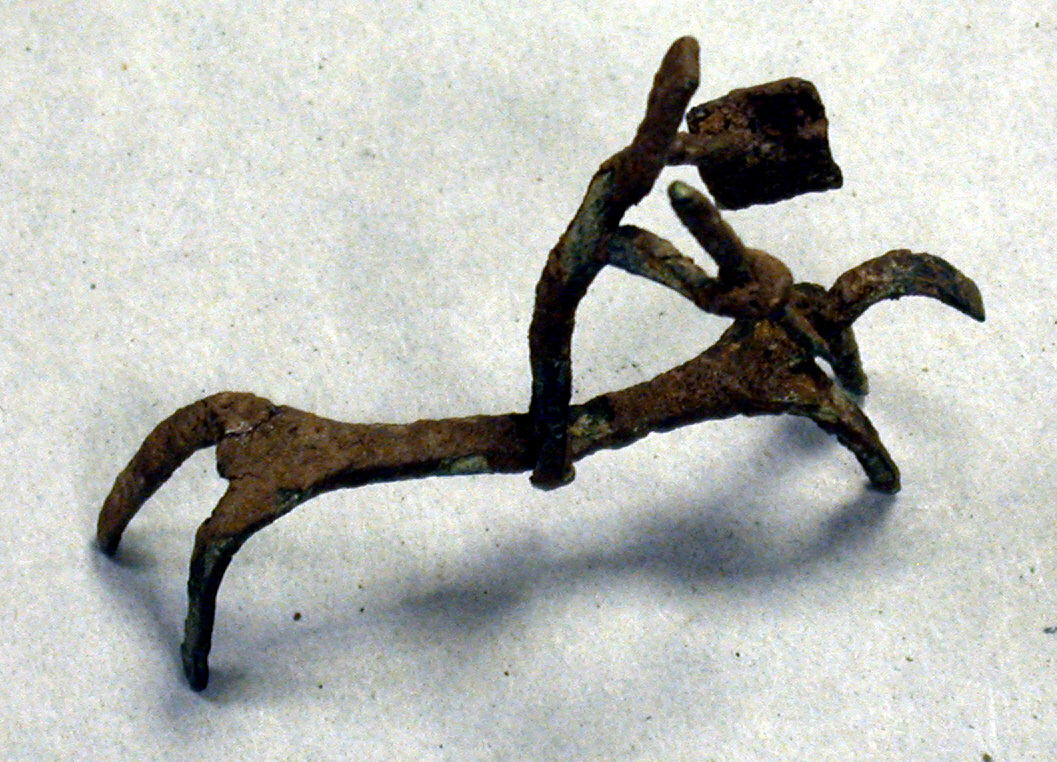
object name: figure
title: Figure: Equestrian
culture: middle niger civilization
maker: middle niger artist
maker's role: artist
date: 1101-1600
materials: copper alloy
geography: mali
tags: horses